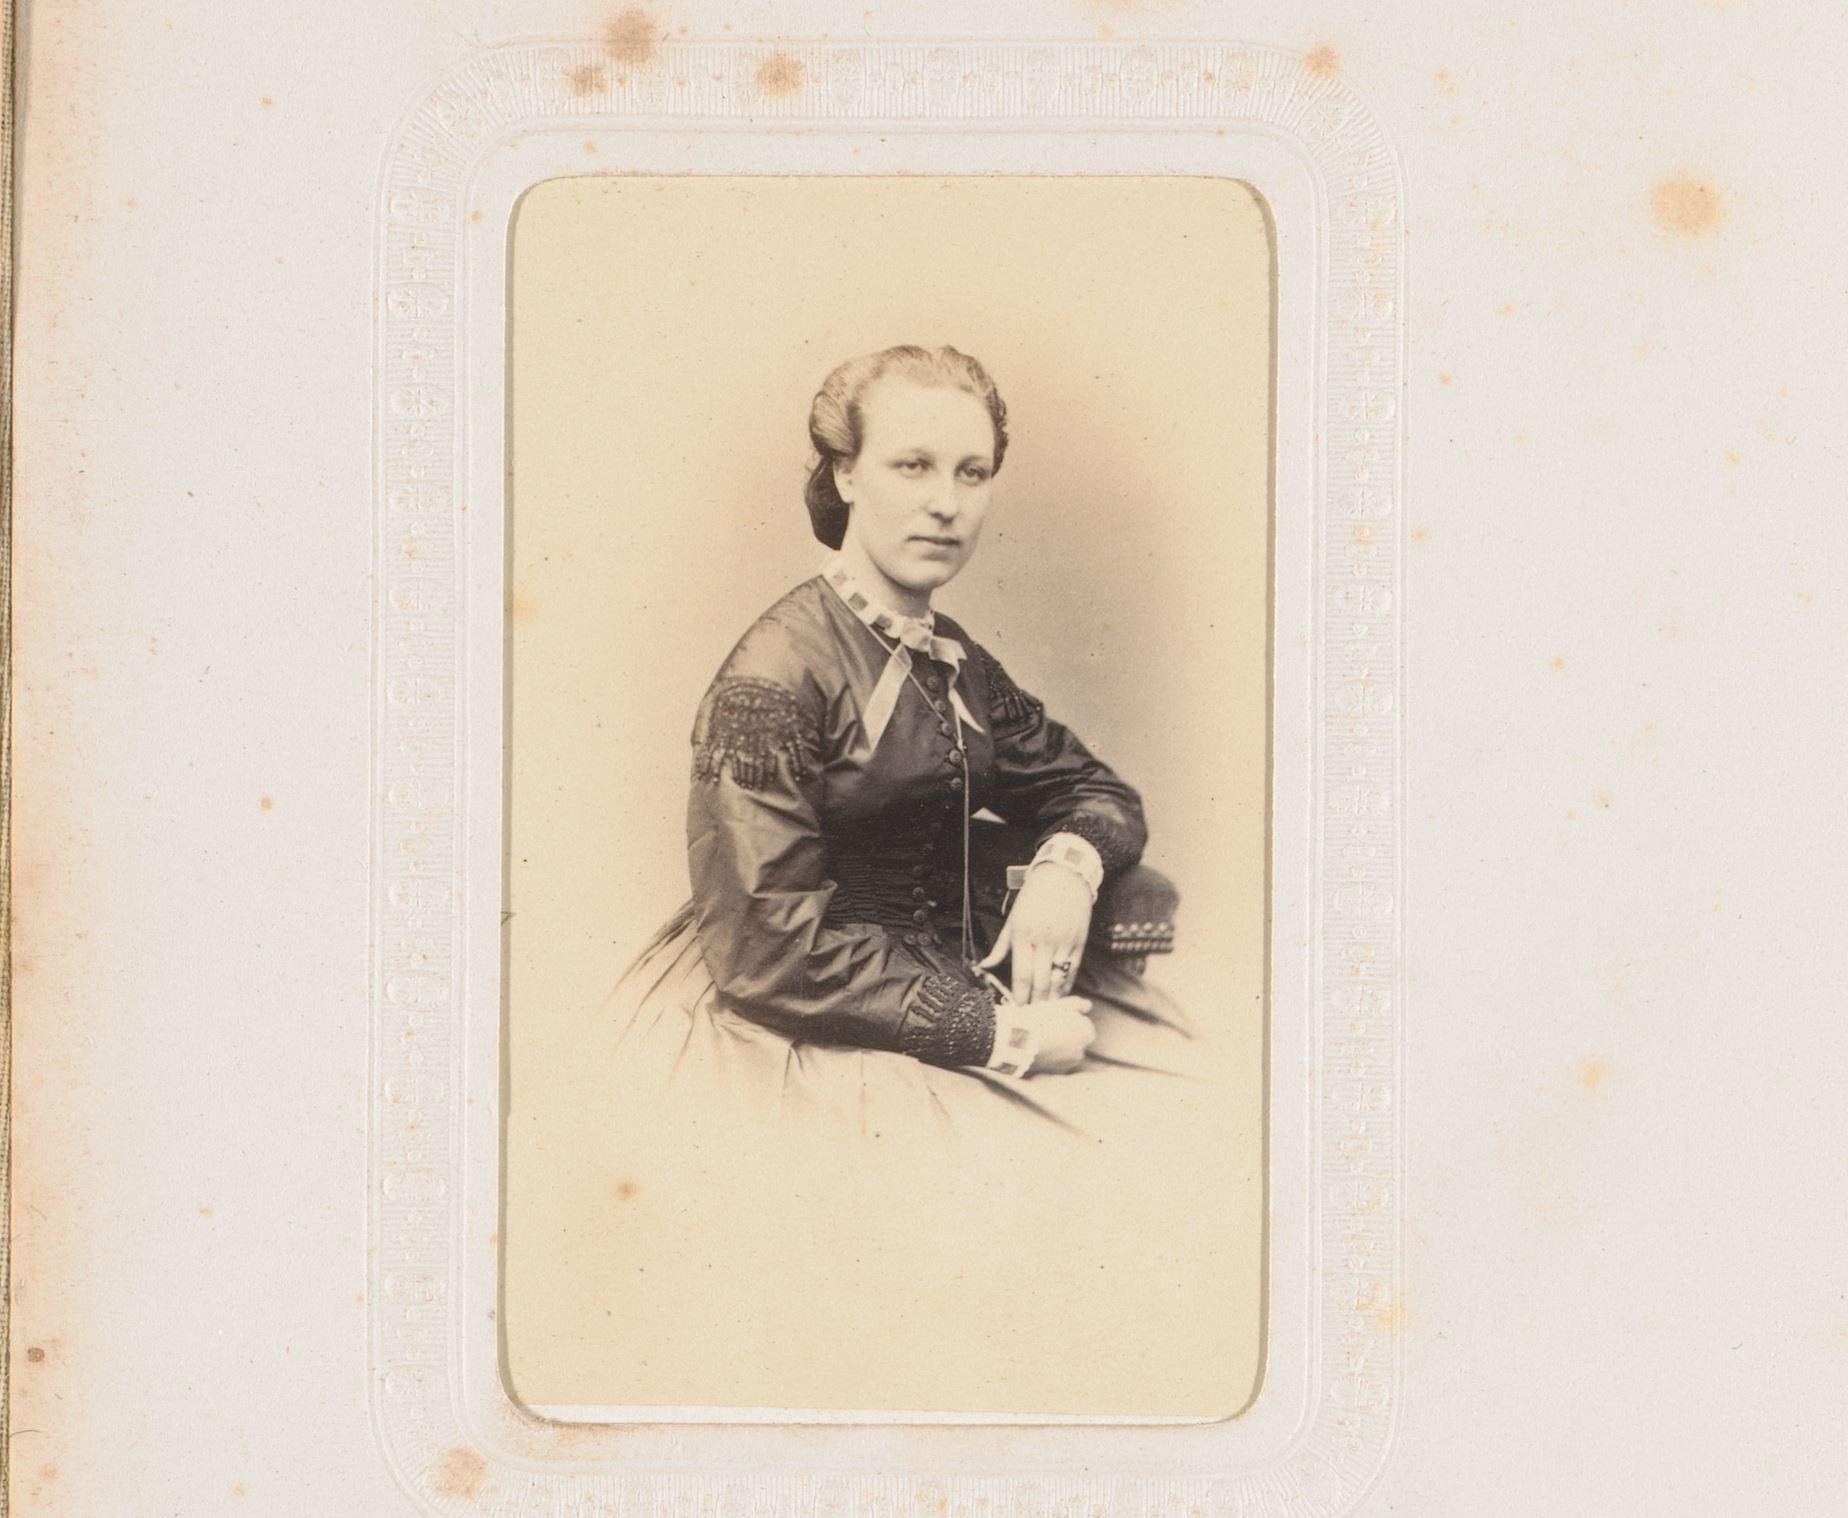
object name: album leaf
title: Portret van een zittende vrouw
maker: Anonymous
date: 1860-1900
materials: cardboard, photographic support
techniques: albumen print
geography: netherlands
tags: sitting figure - aa - female human figure, historical persons - bb - woman